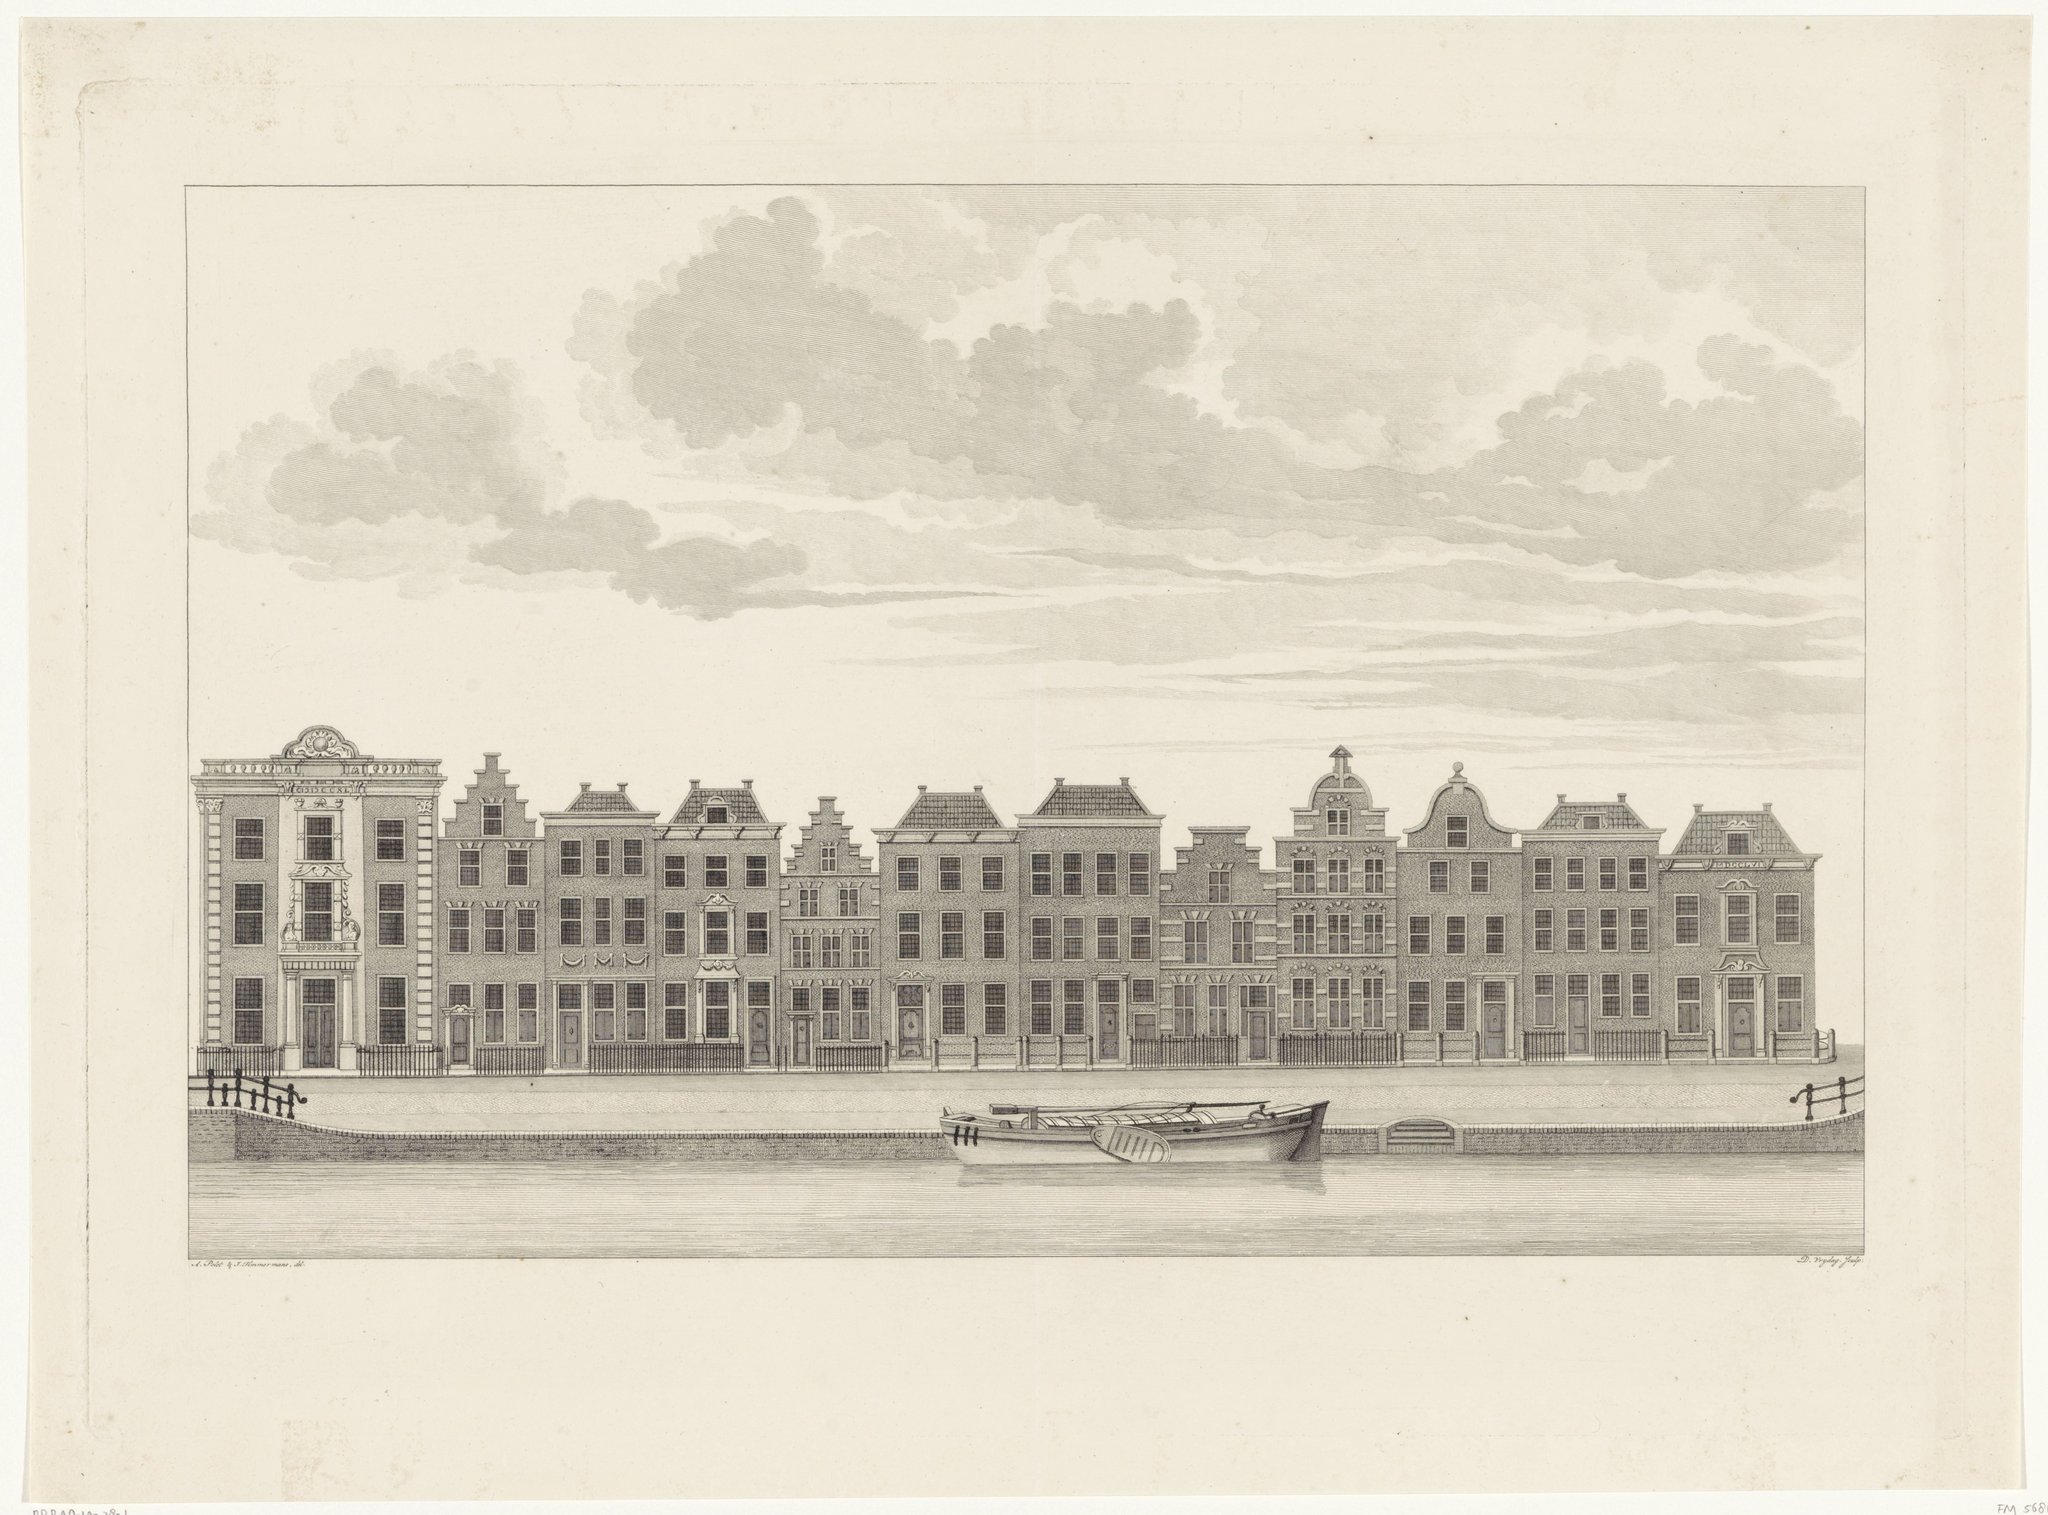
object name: history print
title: Gezicht op de huizen aan het Rapenburg te Leiden, van de Nieuwsteeg tot de Langebrug, voorafgaand aan de ramp van Leiden, 1807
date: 1807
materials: paper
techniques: engraving, etching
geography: amsterdam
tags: façade (of house or building), leiden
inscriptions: collector's mark: Lugt 2228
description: Gezicht op de gevels van de huizen aan het Rapenburg te Leiden, van de Nieuwsteeg tot de Langebrug. Situatie voor de ontploffing van het kruitschip op 12 januari 1807. Met een lege marge.